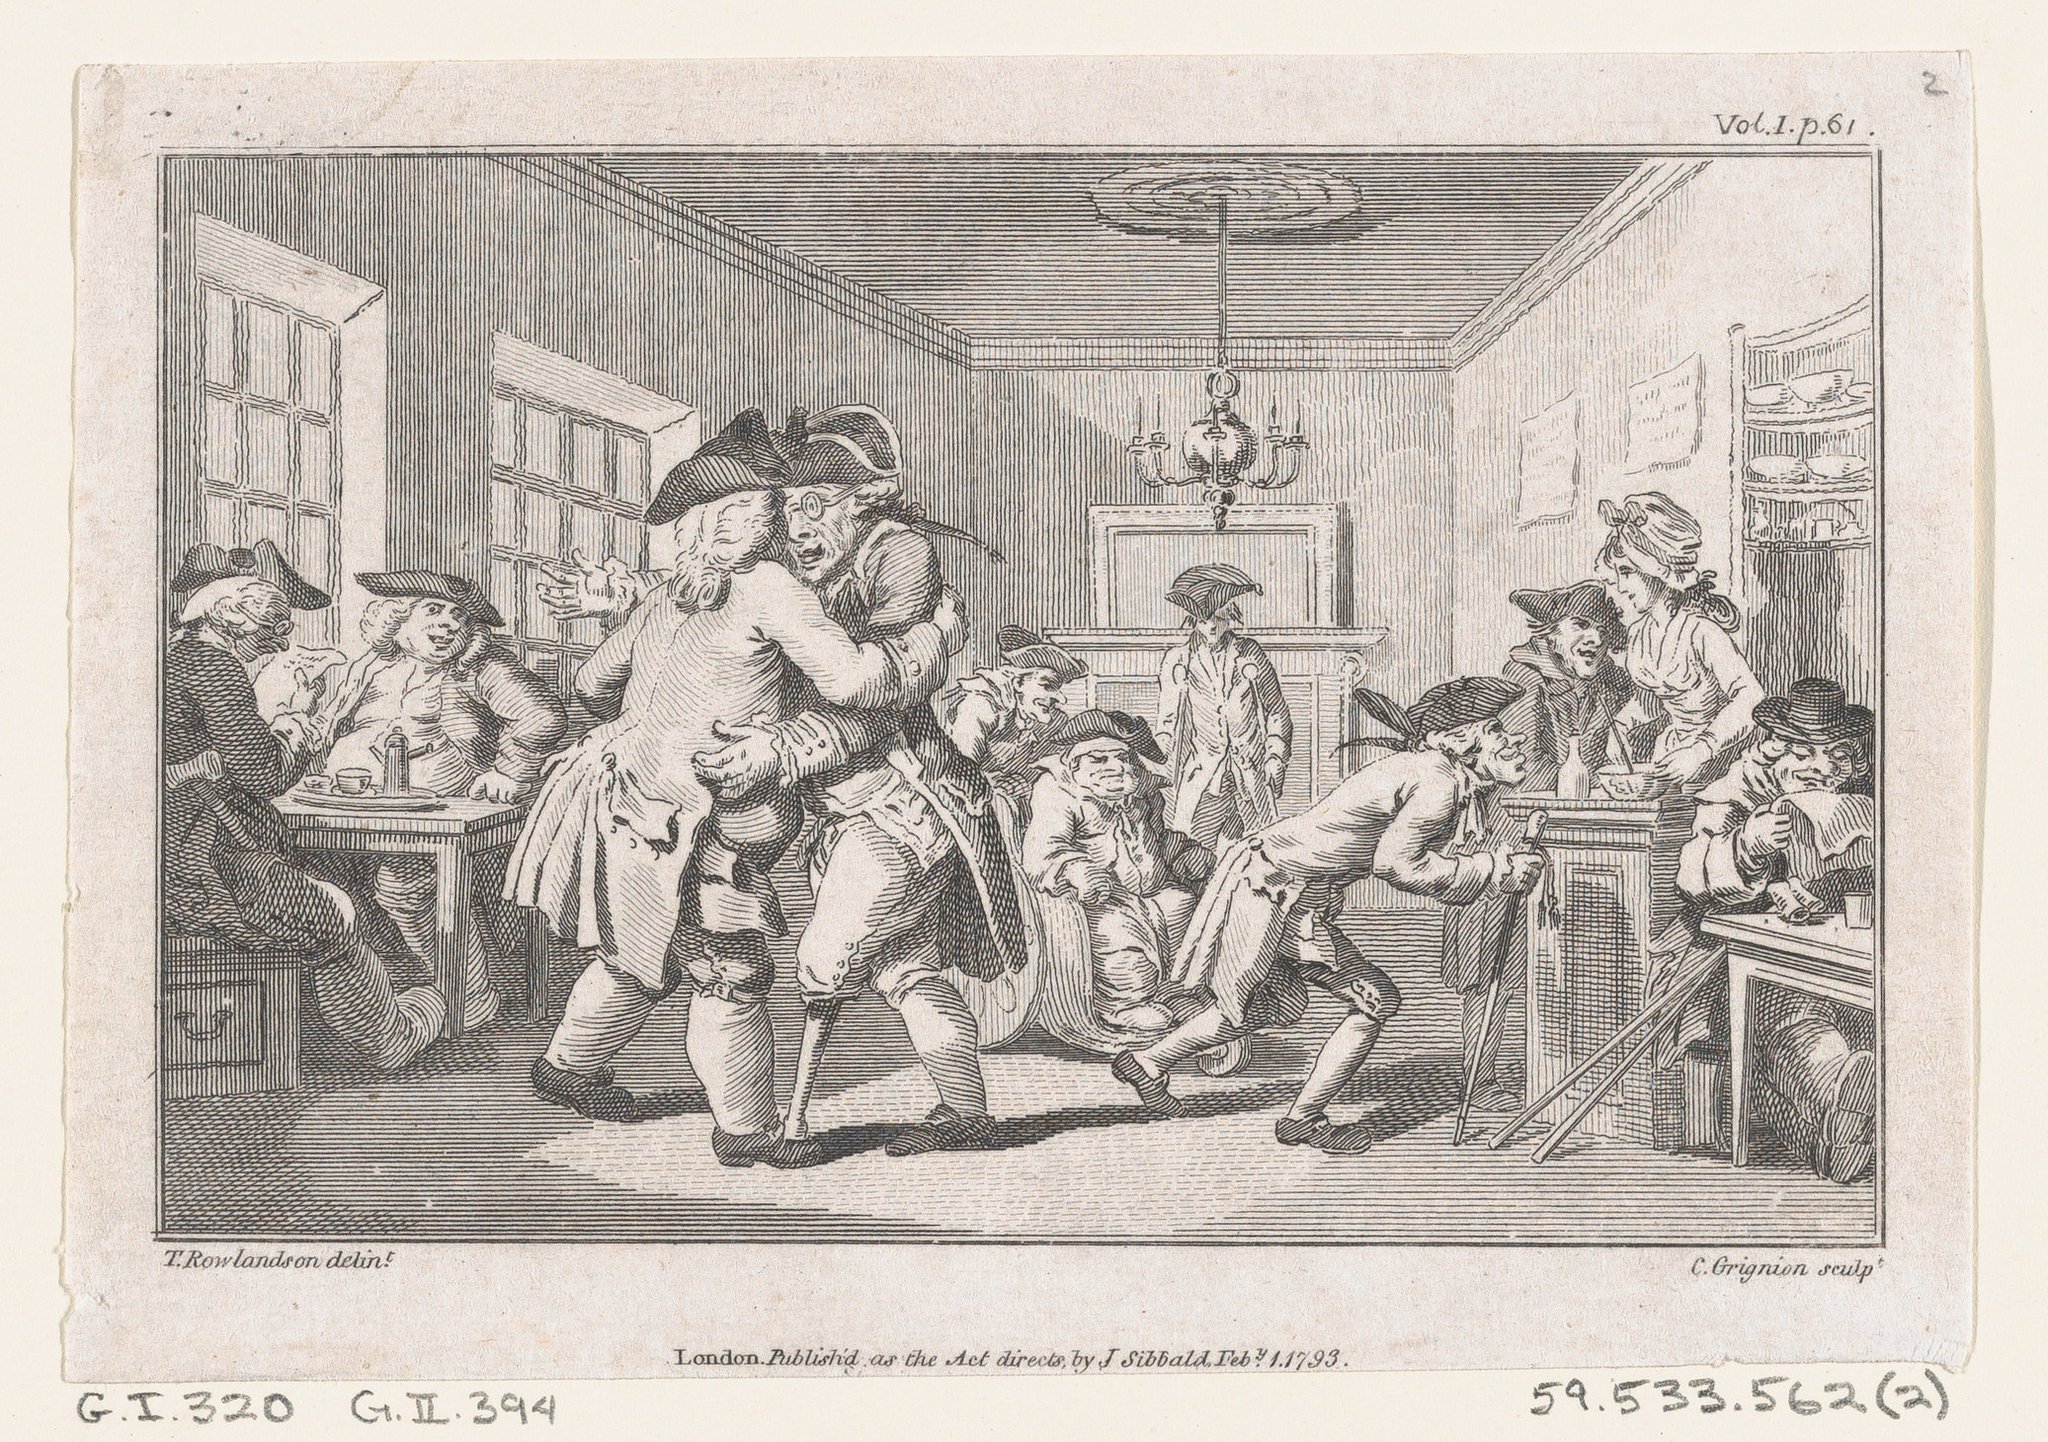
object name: print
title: Men Dancing in a Coffee House, an illustration from Tobias Smollett's "The Expedition of Humphry Clinker" (London, 1793), Vol. 1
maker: charles grignion, i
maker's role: artist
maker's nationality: british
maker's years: 1710-1810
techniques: engraving, etching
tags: satire,restaurants,men,dancing